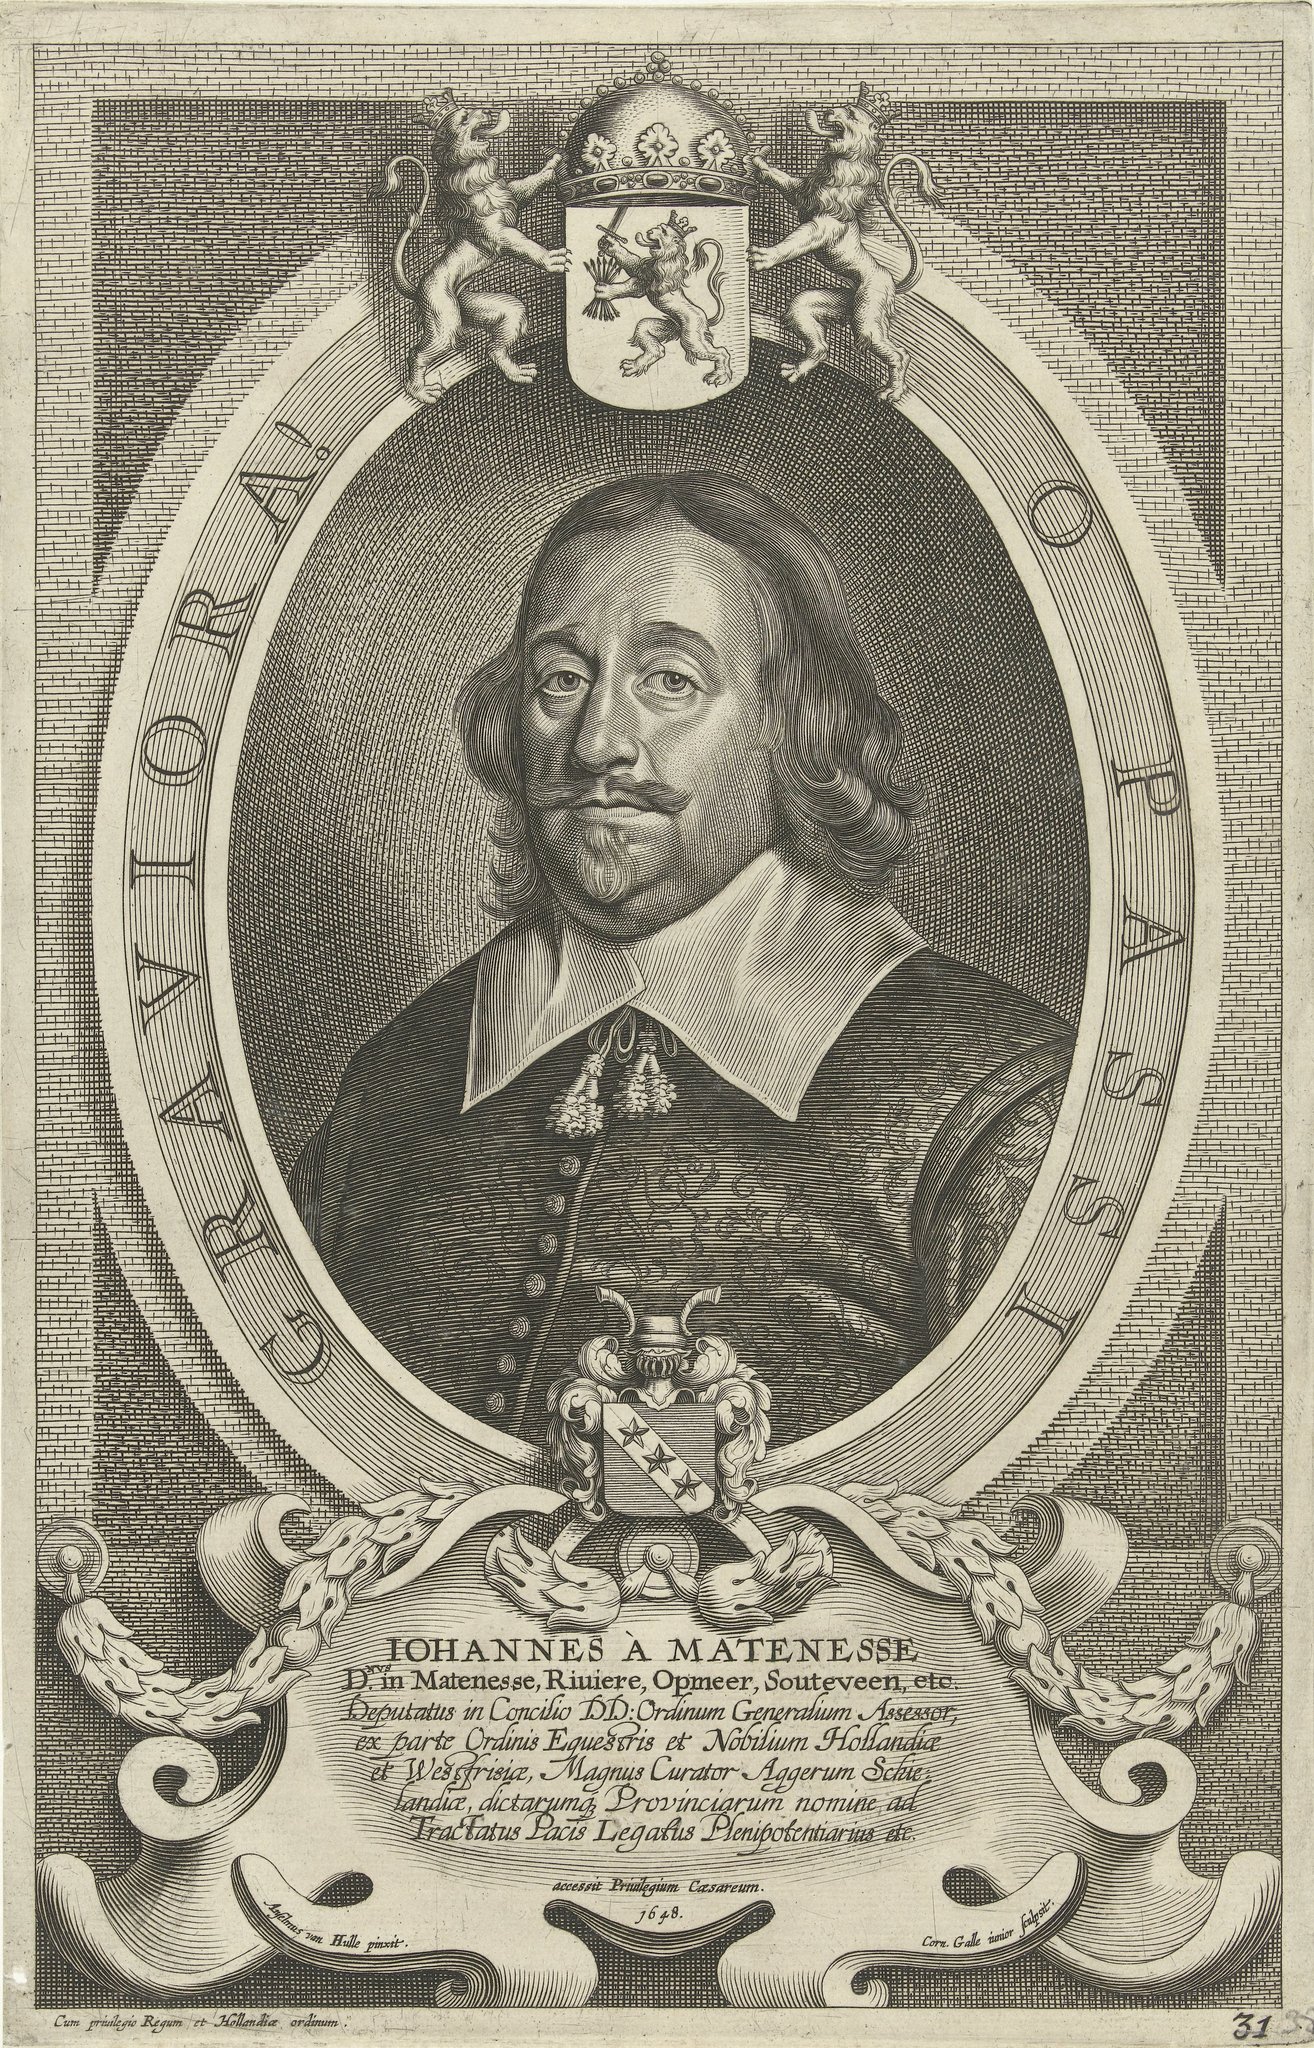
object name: print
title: Portret van Johann van Mathenesse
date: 1648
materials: paper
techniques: engraving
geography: antwerp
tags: staatsman, diplomaat, johan van mathenesse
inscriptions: collector's mark: Lugt 2228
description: Portret van Johann van Mathenesse, in ovaal met randschrift. Van Mathenesse was afgezant van Holland en Westfriesland tijdens de onderhandelingen voor de Vrede van Münster, boven het portret het wapen van Holland en onder zijn familiewapen.